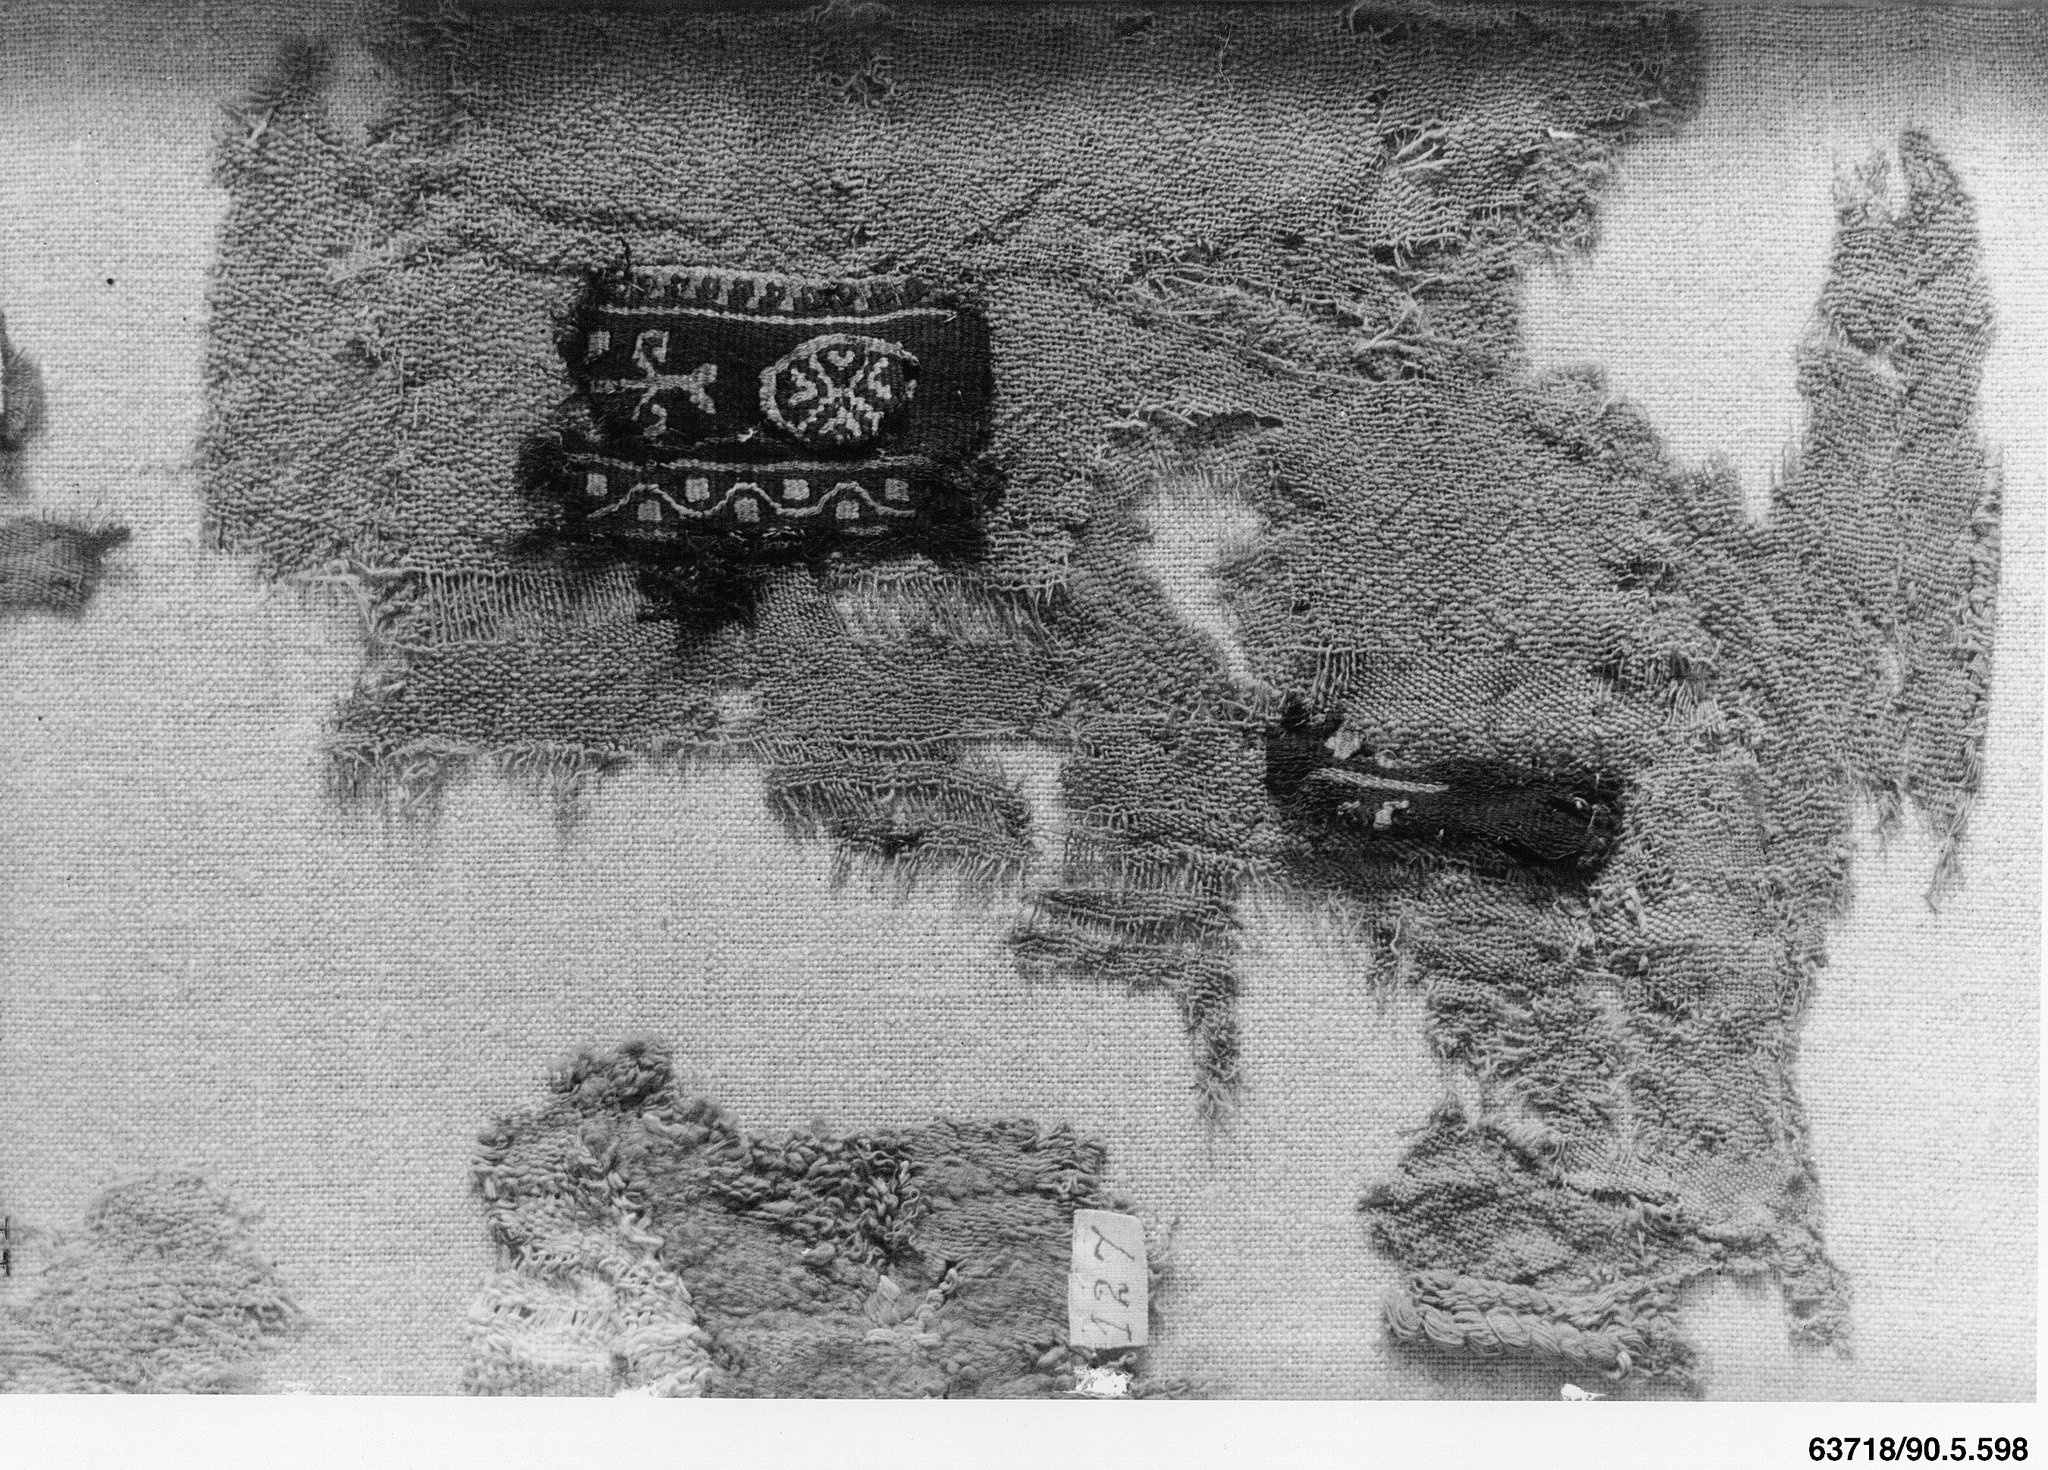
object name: textile fragment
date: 301-400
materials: linen, wool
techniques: weave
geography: egypt